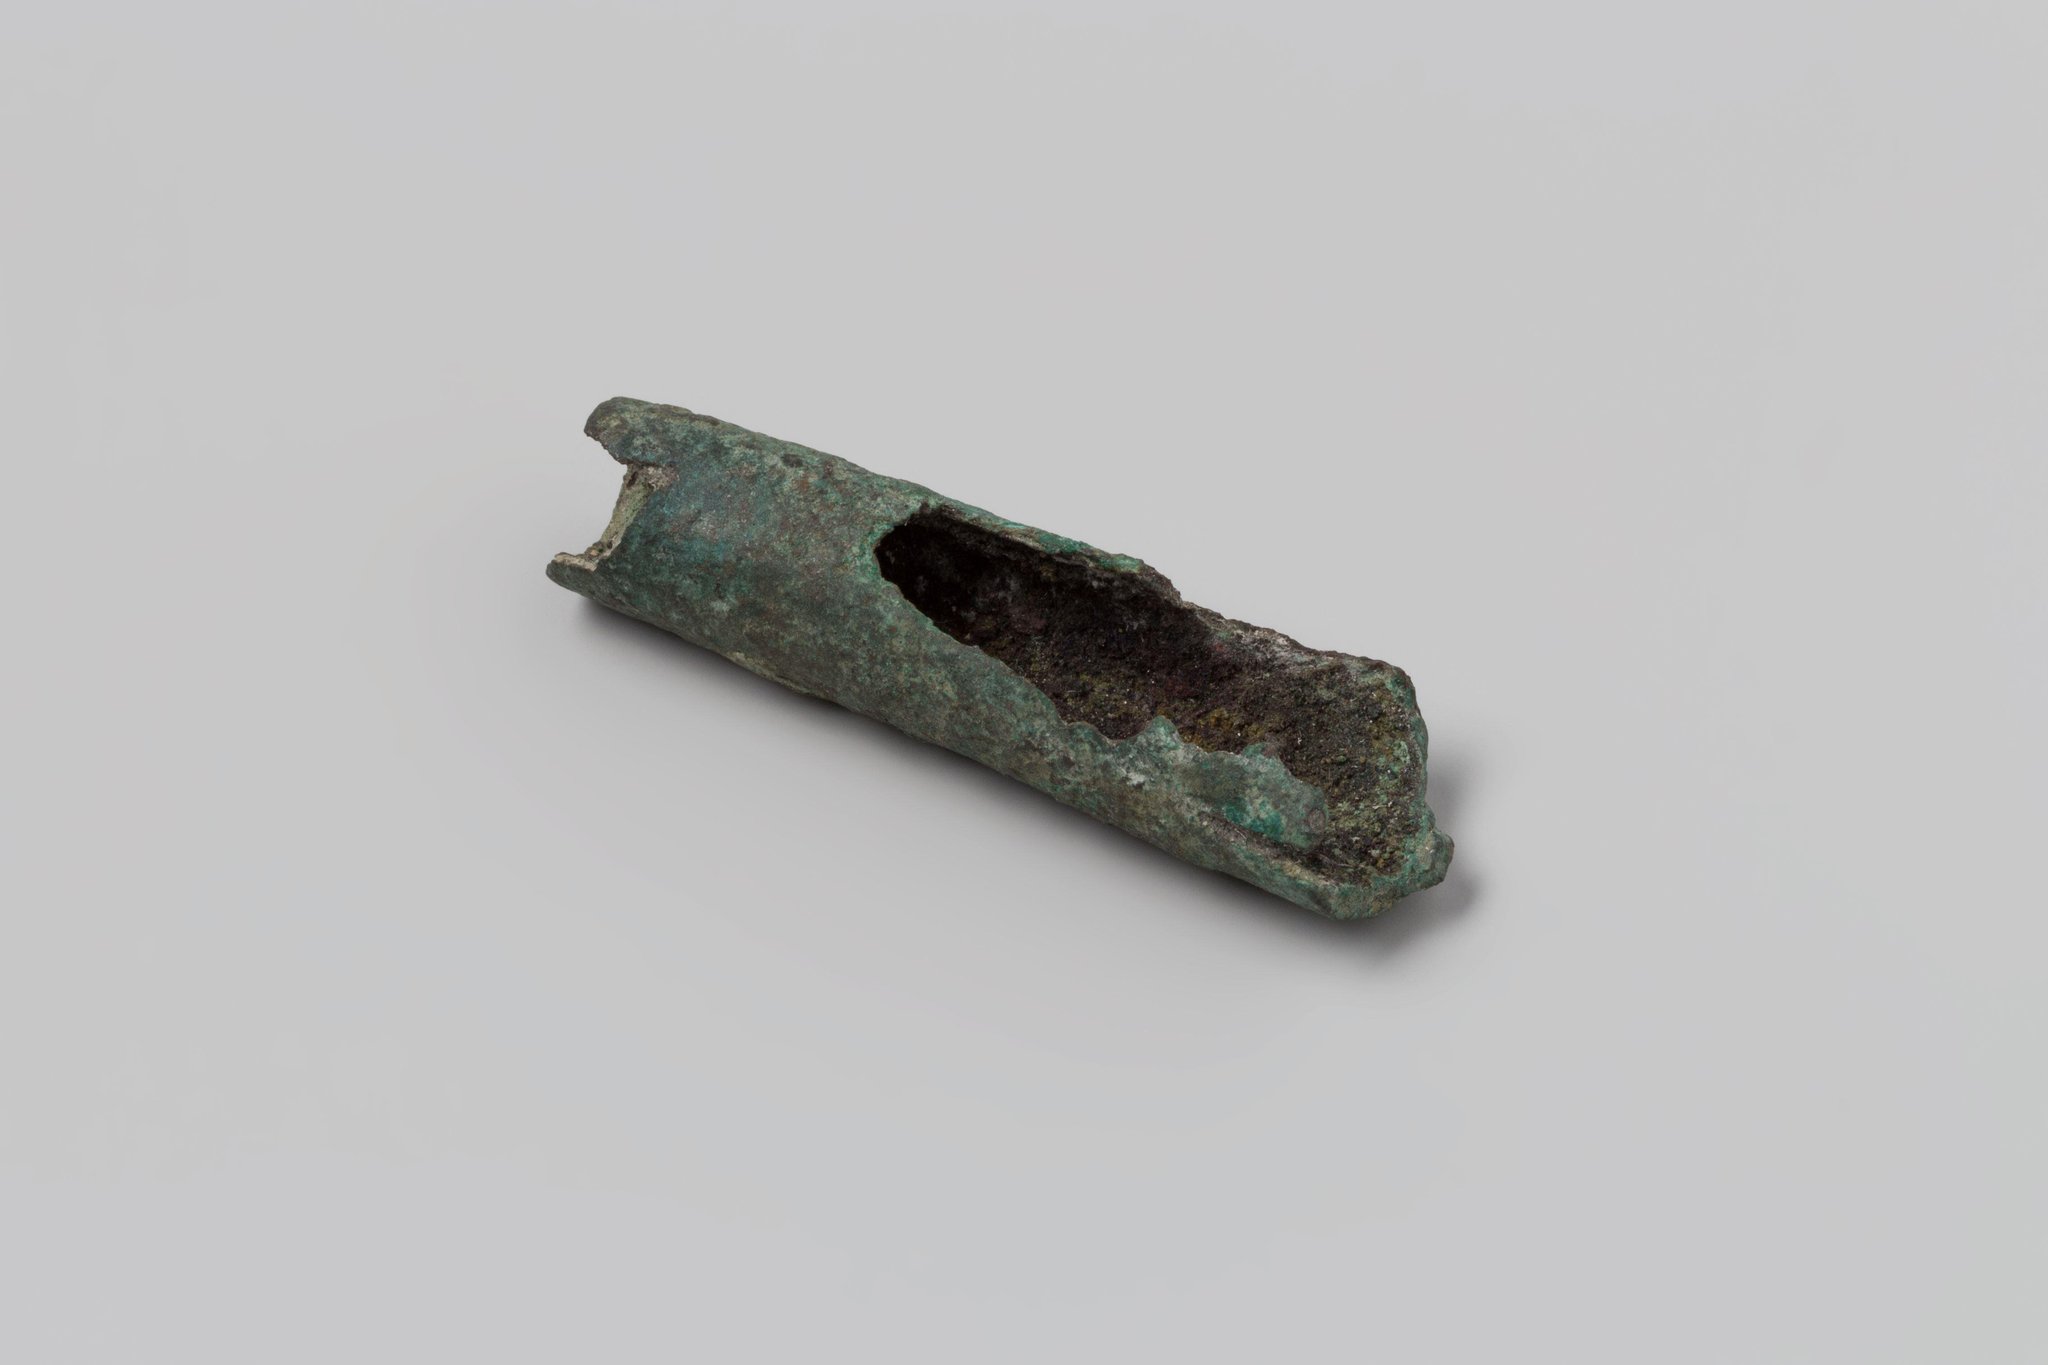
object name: tap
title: Onderdeel kraan uit het wrak van de Oost-Indiëvaarder Hollandia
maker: Anonymous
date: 1700-1743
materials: copper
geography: netherlands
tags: verenigde oostindische compagnie, hollandia (schip), annet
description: Tap, part of tap; fragm, end, id. NG 1979-521H.